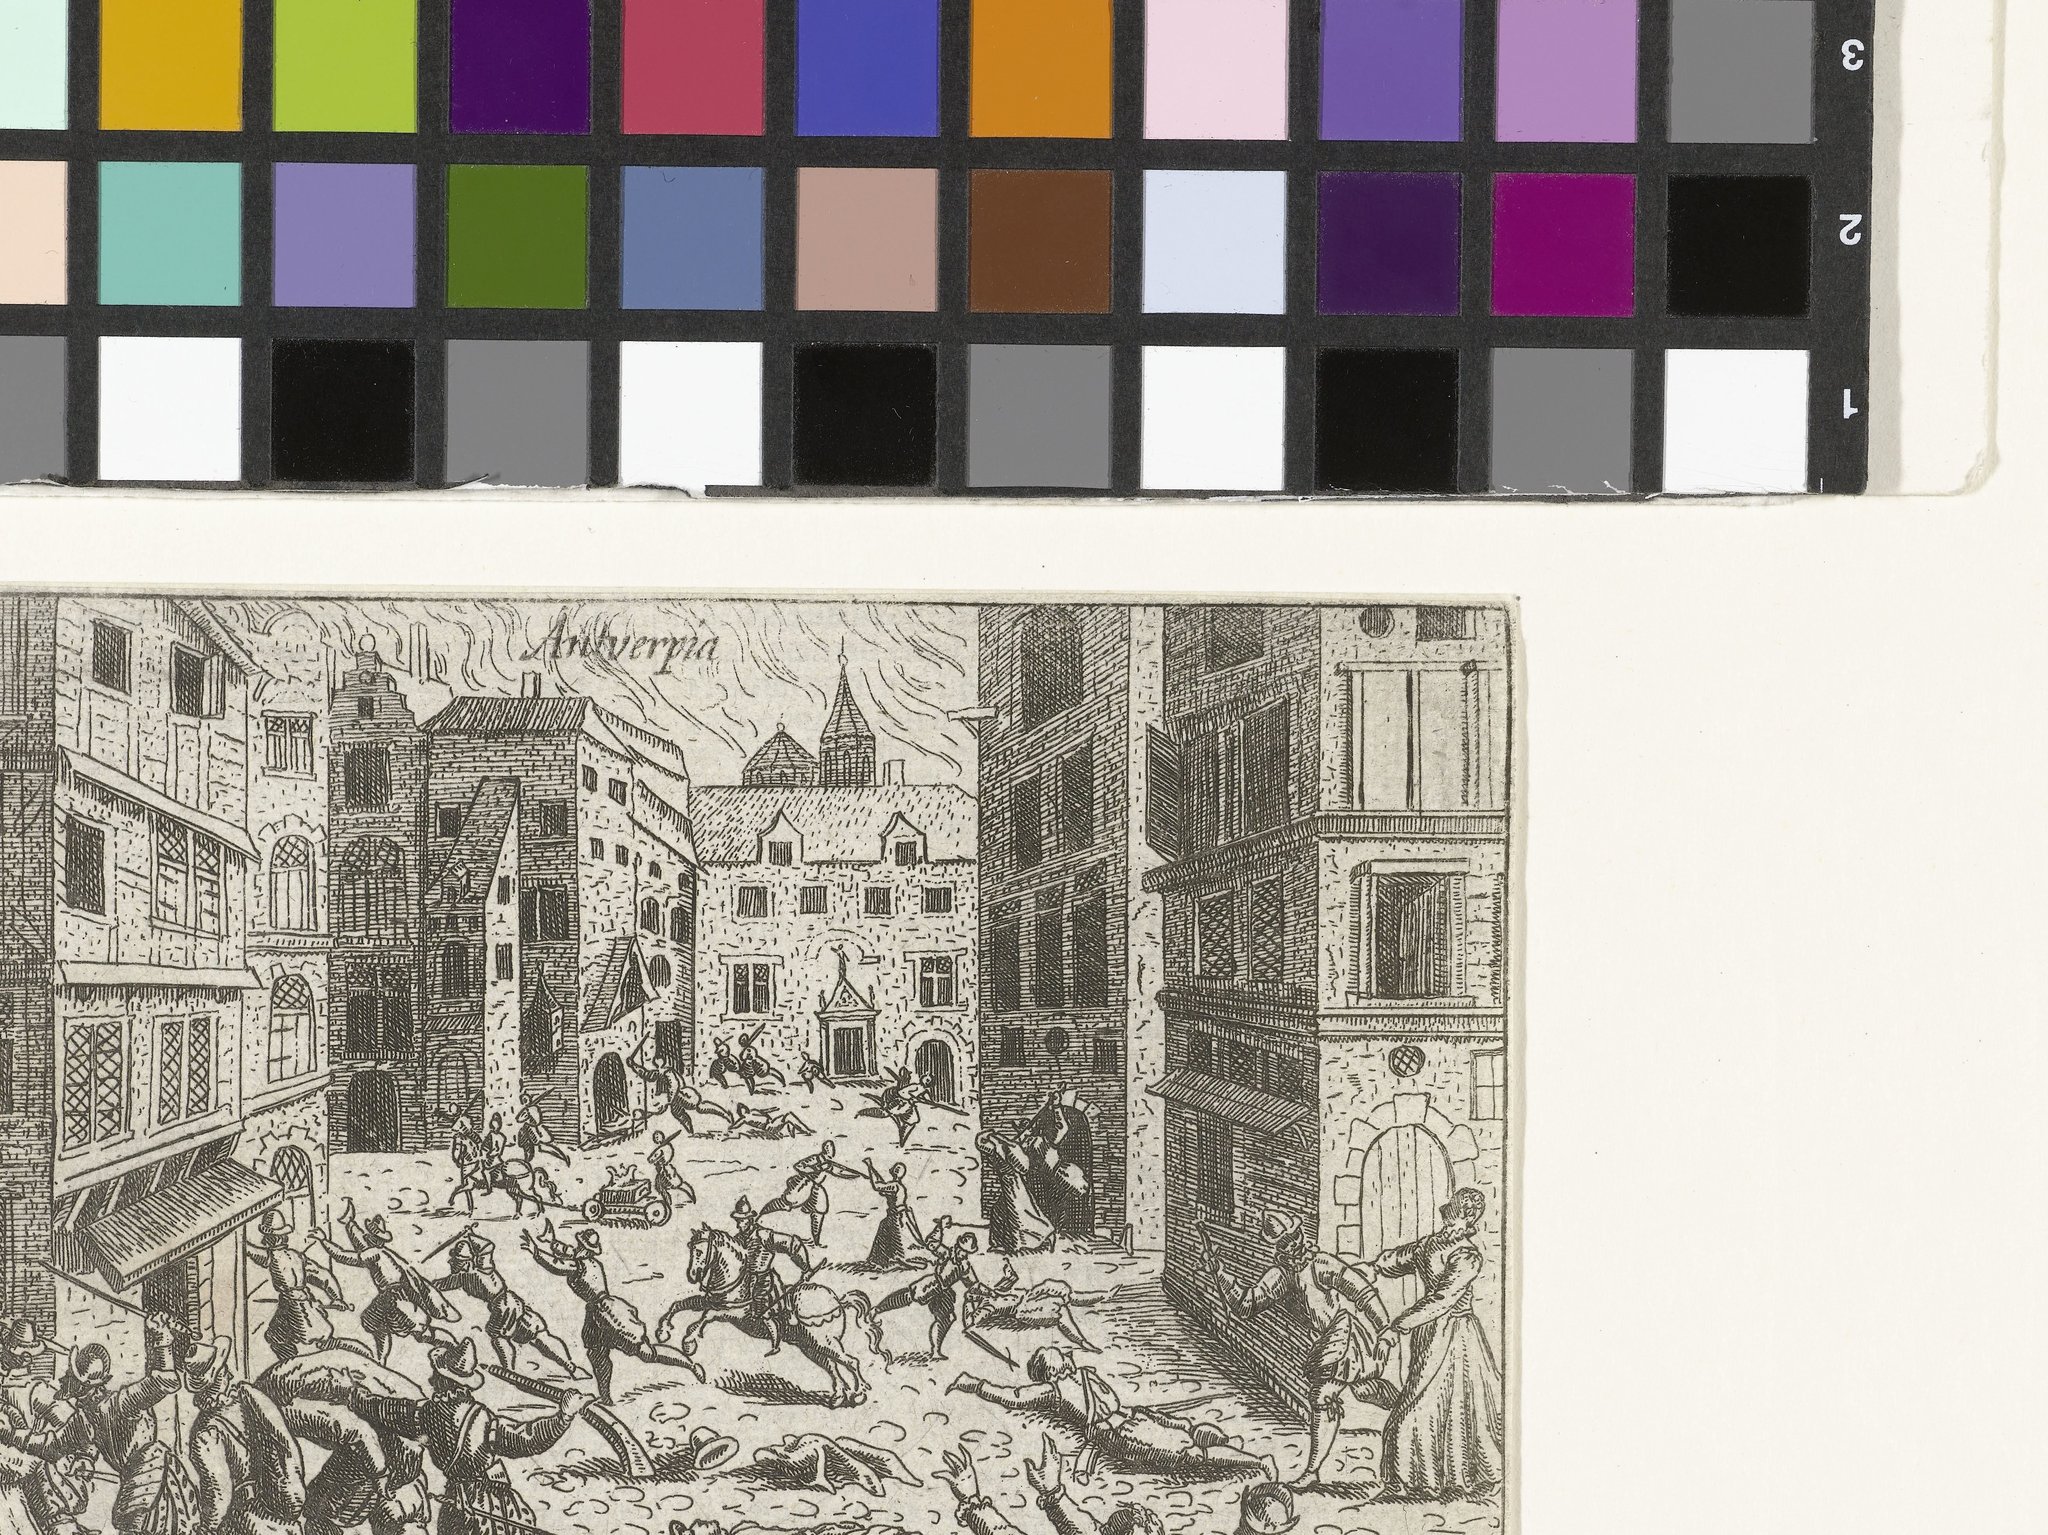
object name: history print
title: Spaanse Furie: moord in de straten, 1576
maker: Anonymous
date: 1613-1615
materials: paper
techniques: etching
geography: northern netherlands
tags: massacre ~ war, antwerp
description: Illustratie afkomstig uit P. Bor Christiaensz., Oorsprongh, begin, ende vervolgh der Nederlantsche oorloghen, in XVIII. boecken waerachtelijck en onpartydelijck beschreven, M. Colijn, Amsterdam 1621-1634, 6 delen, dl. I (1621), 9e boek, fol. 185.